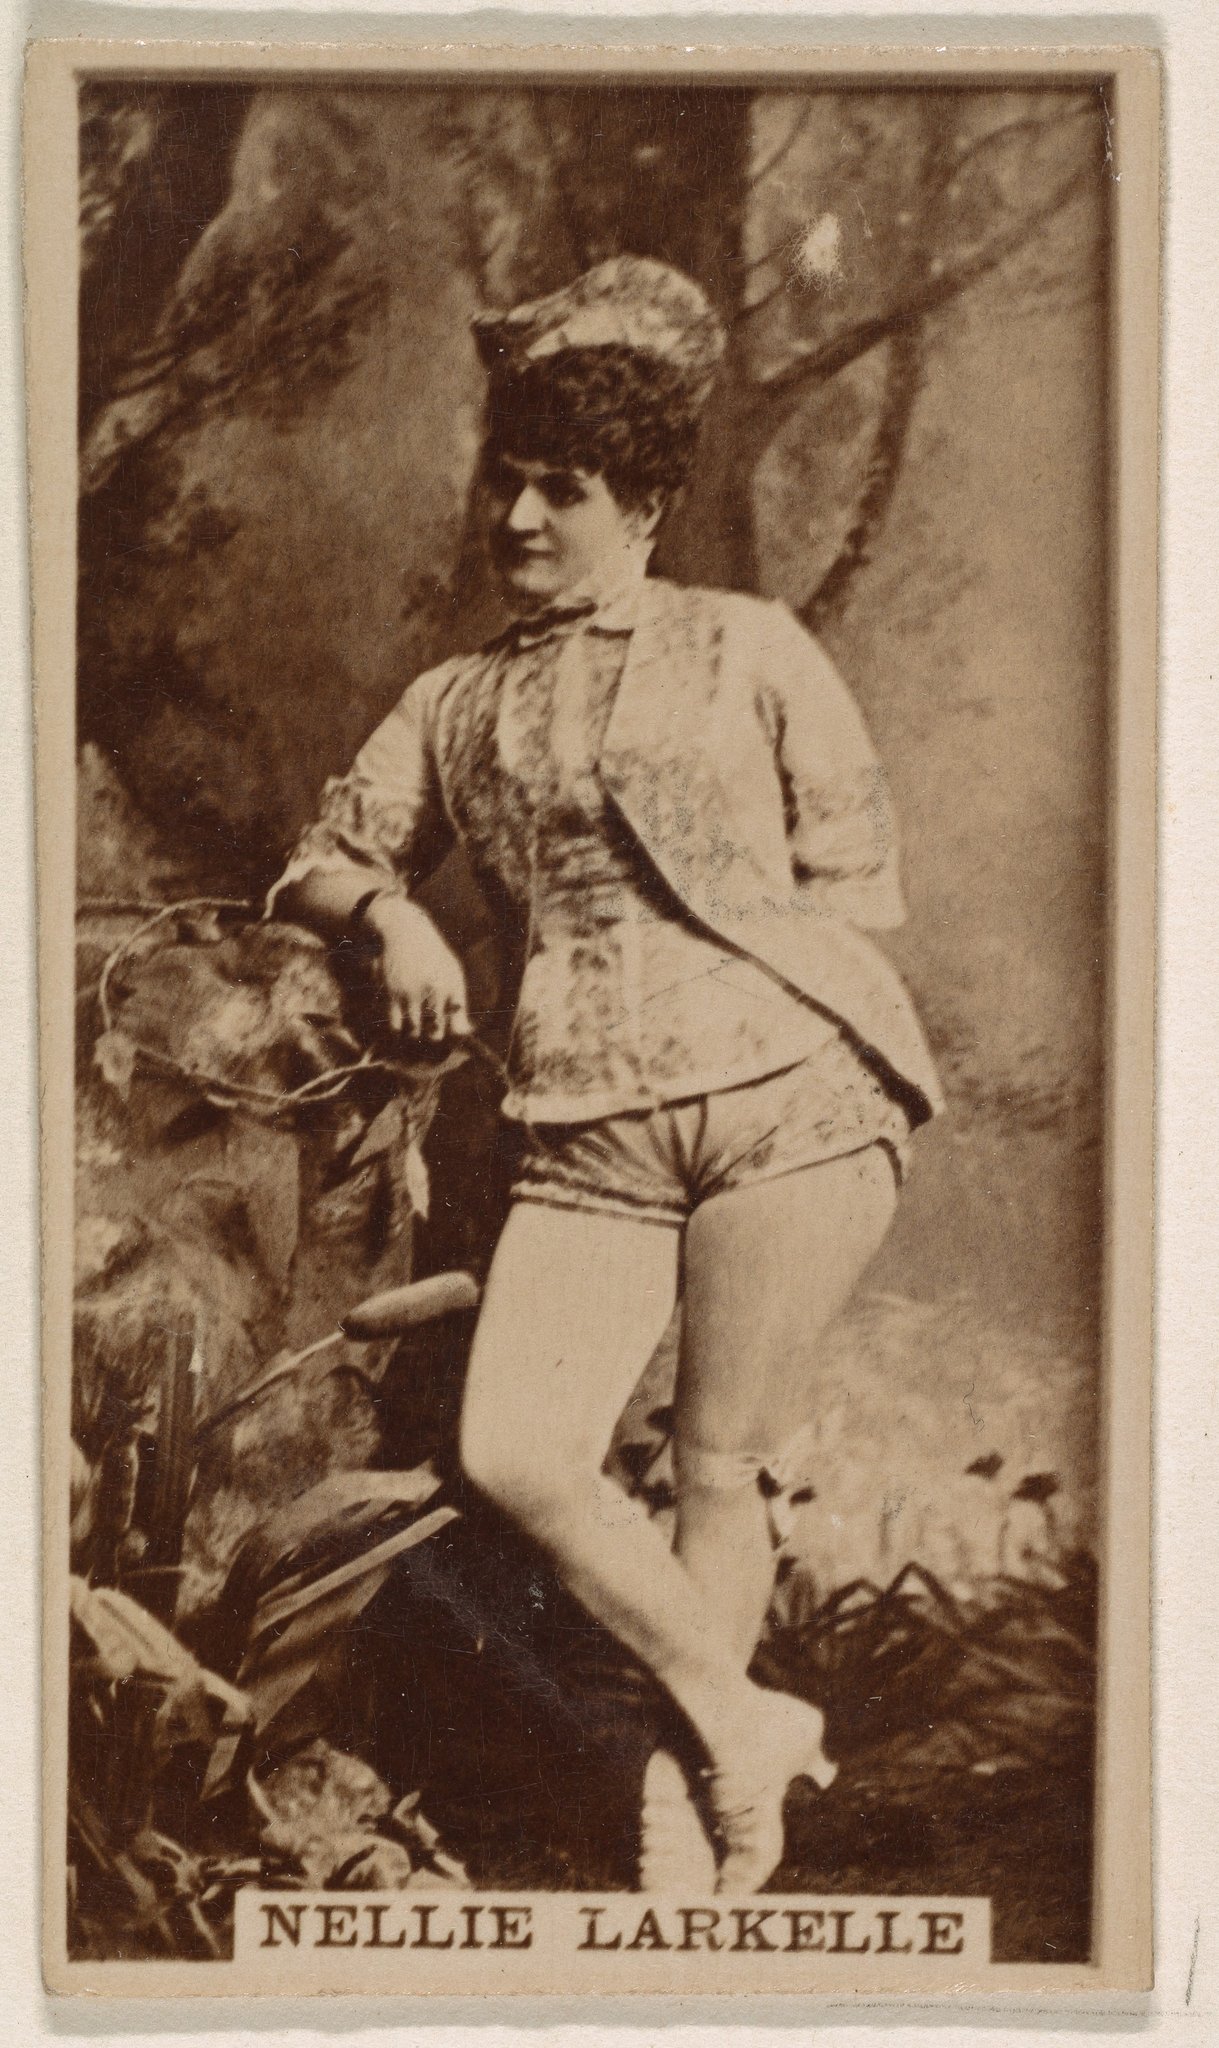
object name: photograph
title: Nellie Larkelle, from the Actresses series (N245) issued by Kinney Brothers to promote Sweet Caporal Cigarettes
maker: kinney brothers tobacco company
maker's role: publisher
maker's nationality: american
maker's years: 1869-2011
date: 1890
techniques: albumen silver print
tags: portraits,women,actresses